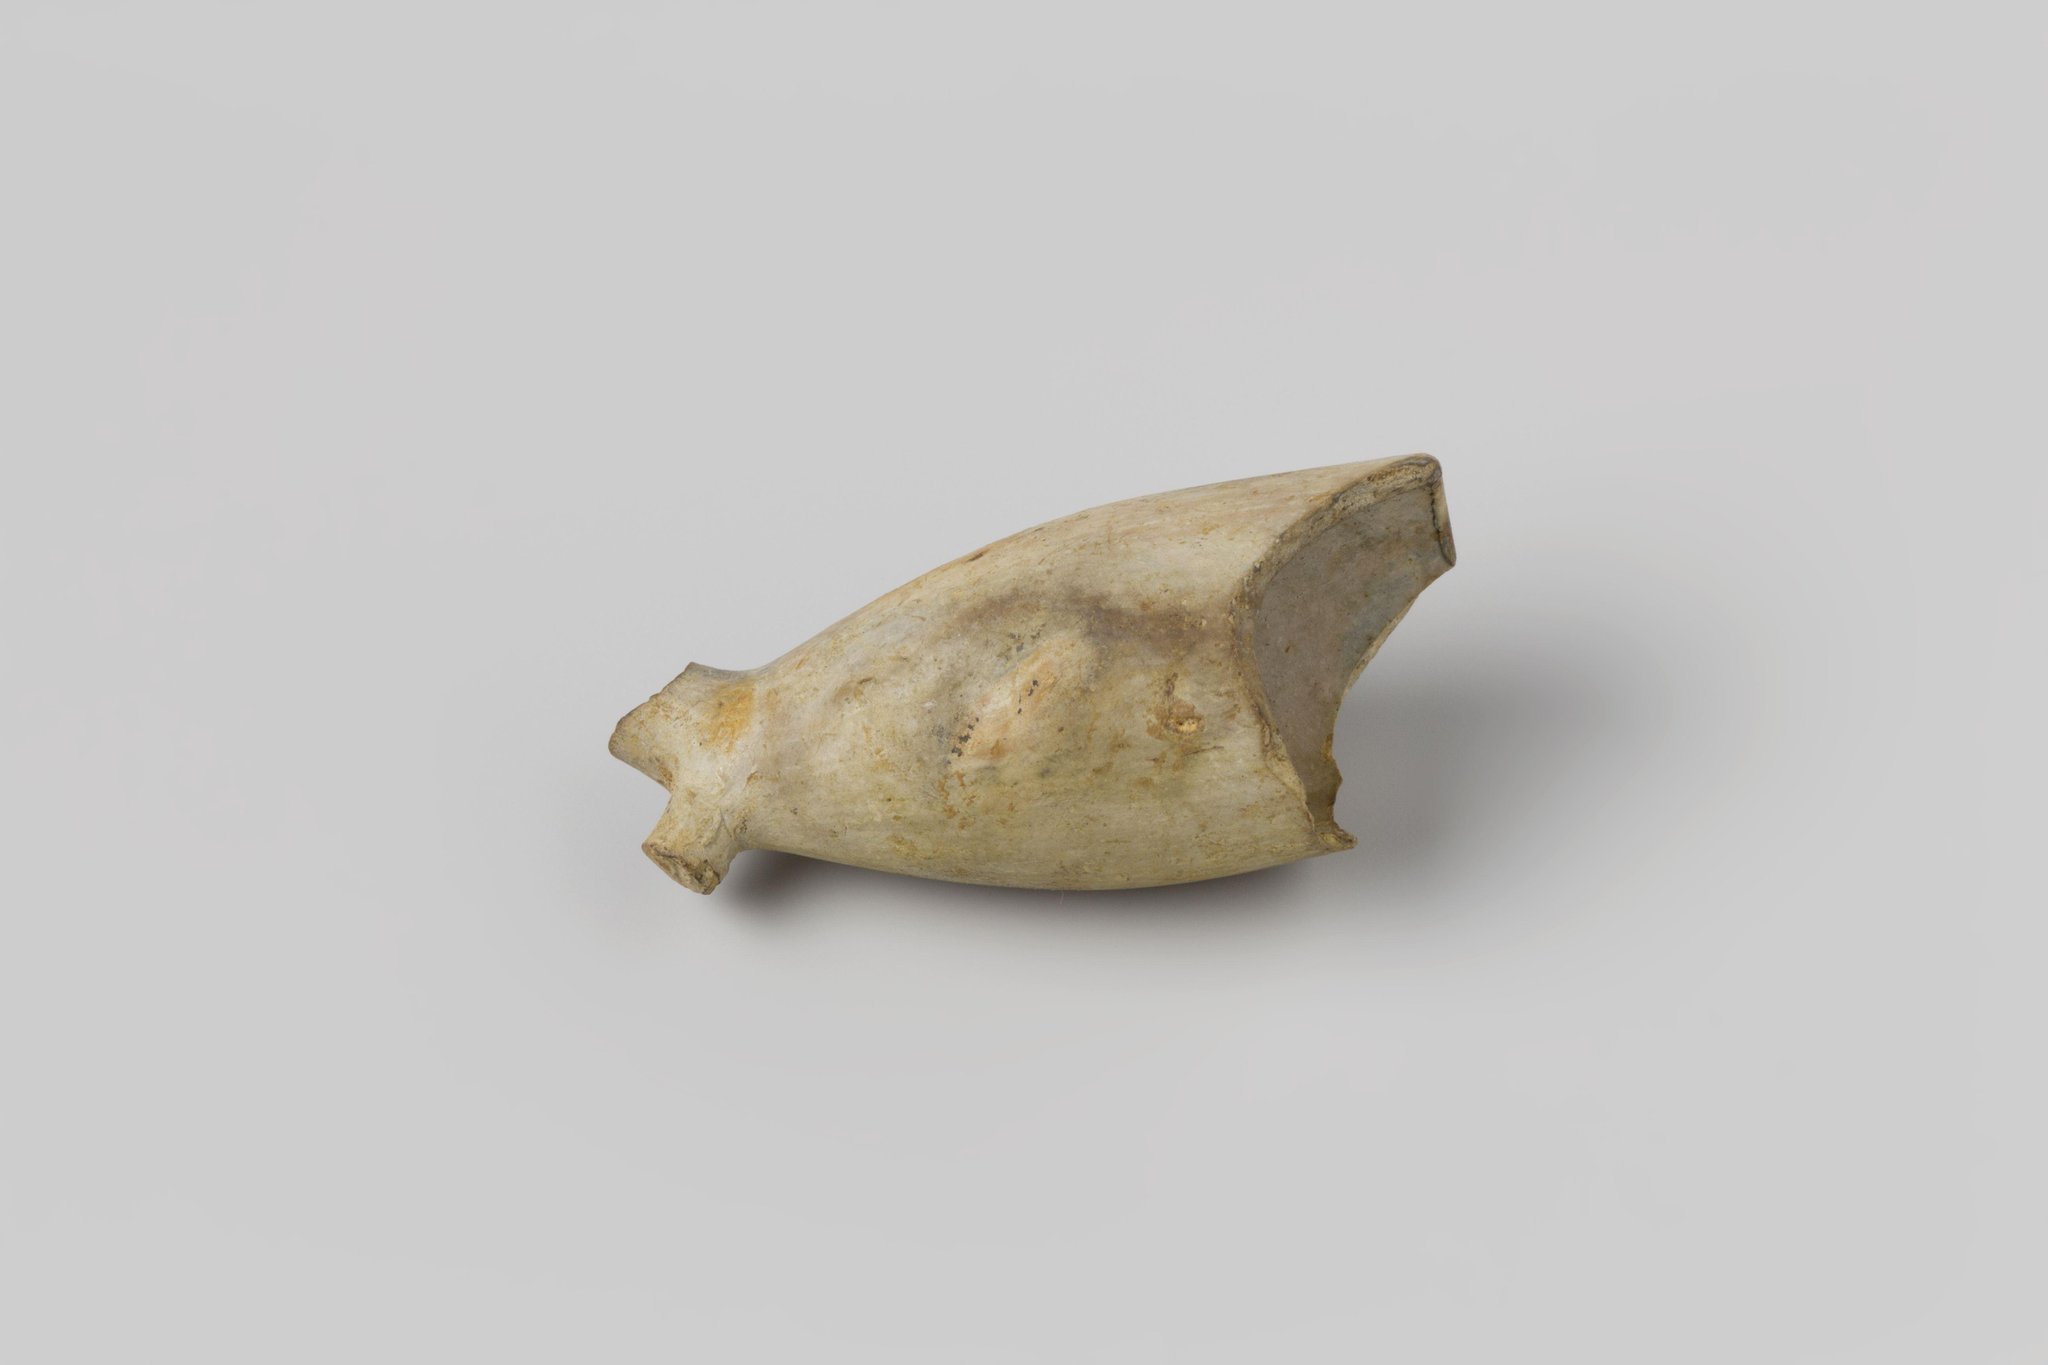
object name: pipe bowl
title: Fragment pijpenkop uit het wrak van de Oost-Indiëvaarder Hollandia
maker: Anonymous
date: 1700-1743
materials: clay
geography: netherlands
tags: verenigde oostindische compagnie, hollandia (schip), annet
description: Pipe, bowl, heelmark: crowned 47; fragment, 2hsm2.